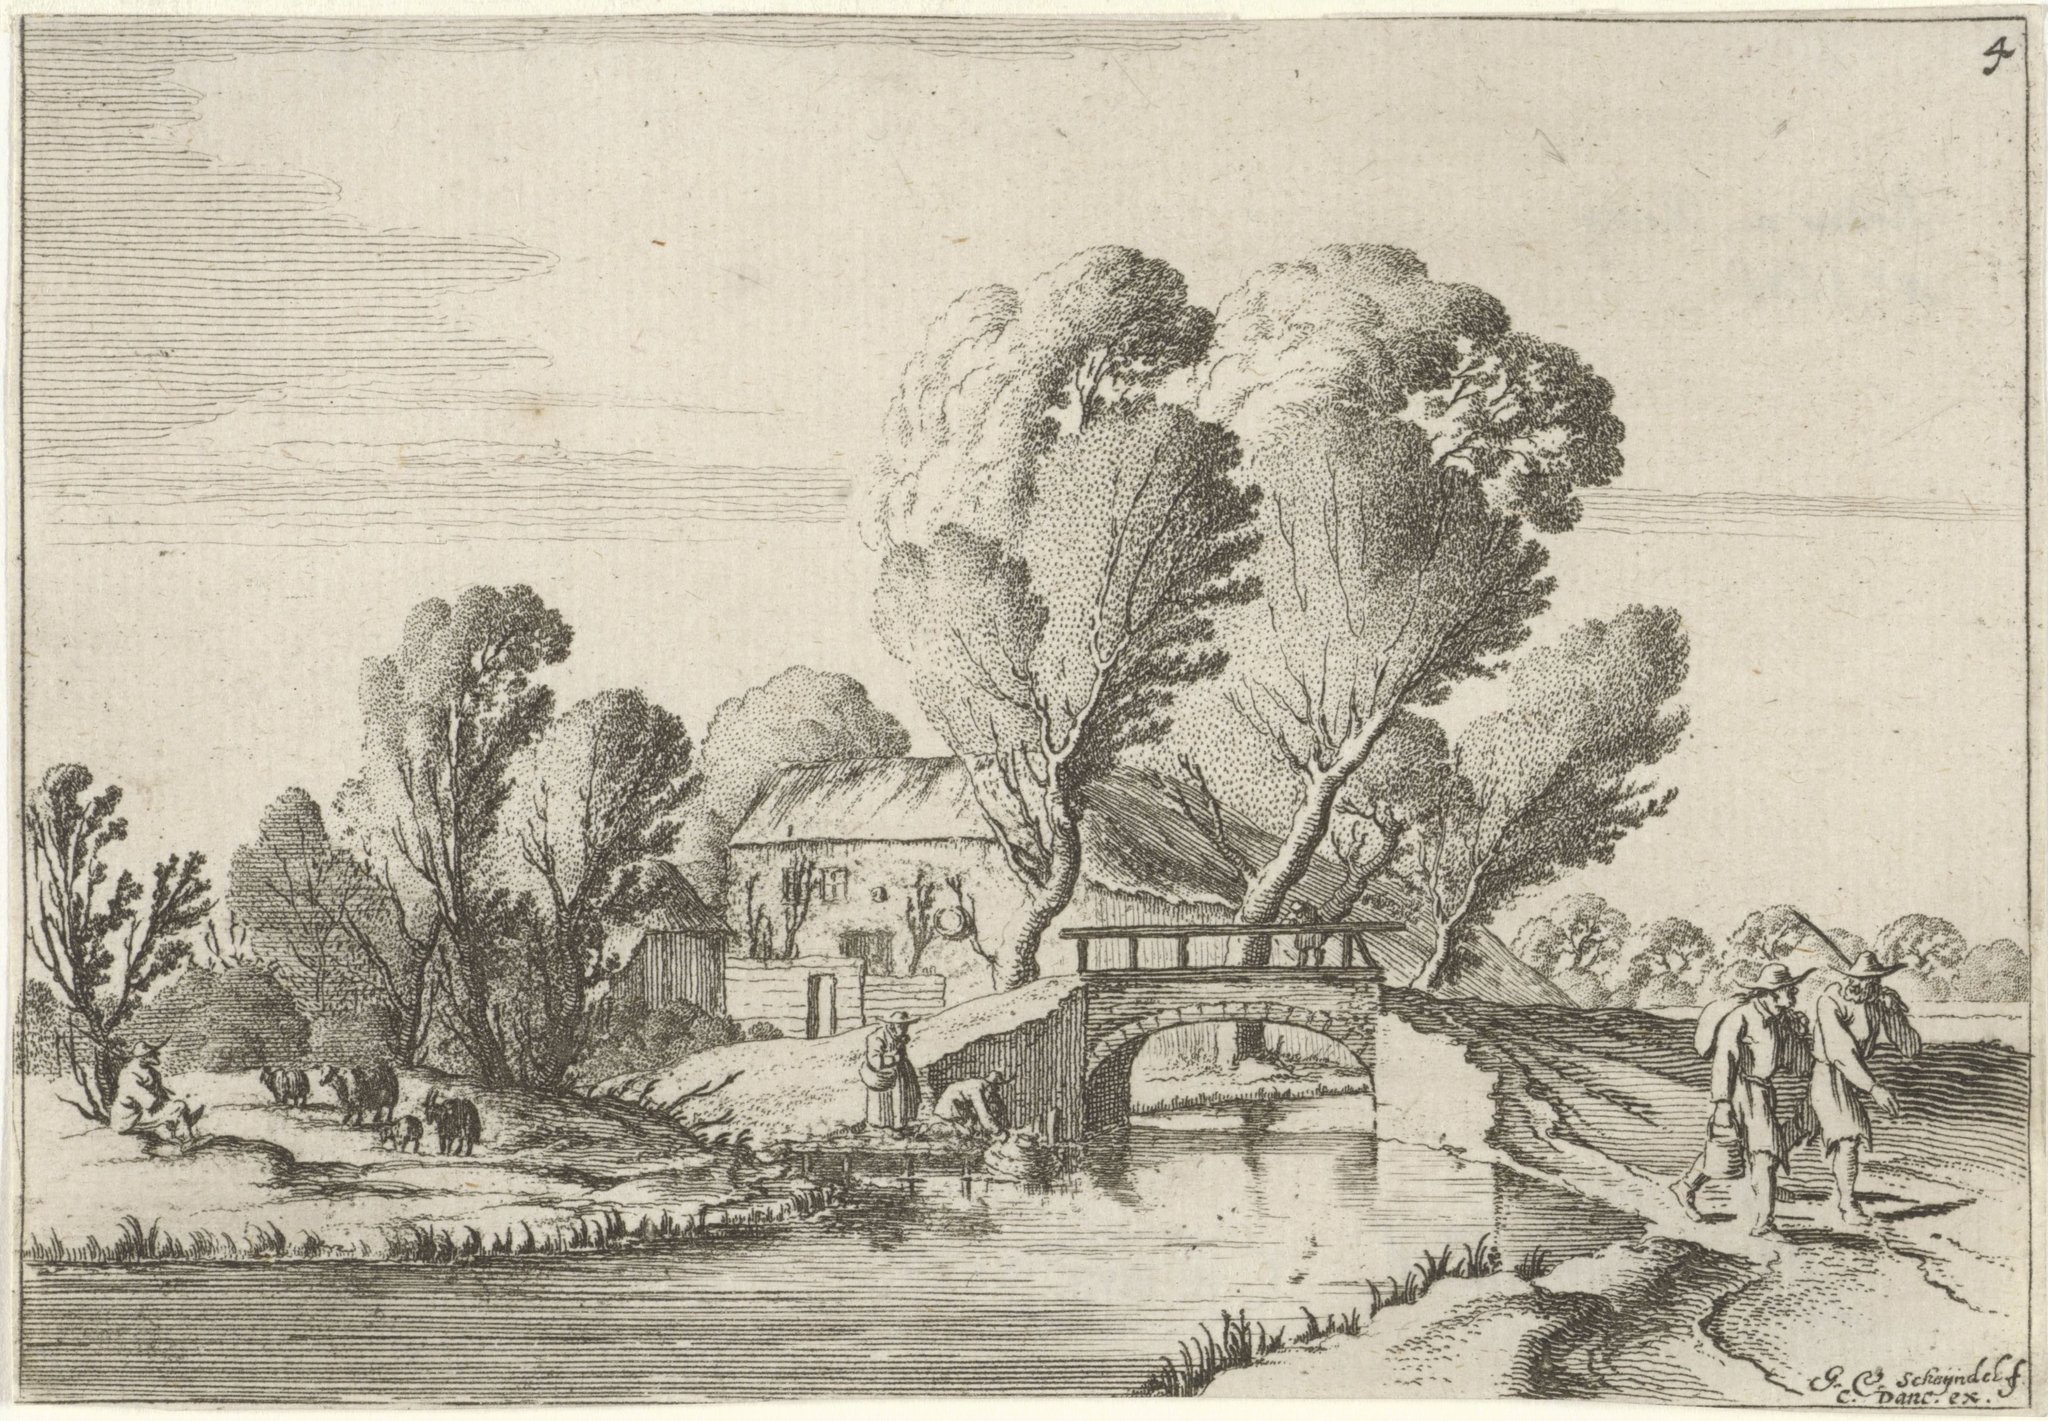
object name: print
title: Zeven landschappen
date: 1631-1656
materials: paper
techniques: engraving, etching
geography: amsterdam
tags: canal, groups of trees, 'en route', traveller under way, farm or solitary house in landscape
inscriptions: collector's mark: Lugt 2228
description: In een boomrijk landschap lopen twee wandelaars over een pad langs een kanaal. Achter de brug (over het kanaal) ligt een boerderij. De prent maakt deel uit van een serie van zeven landschappen.